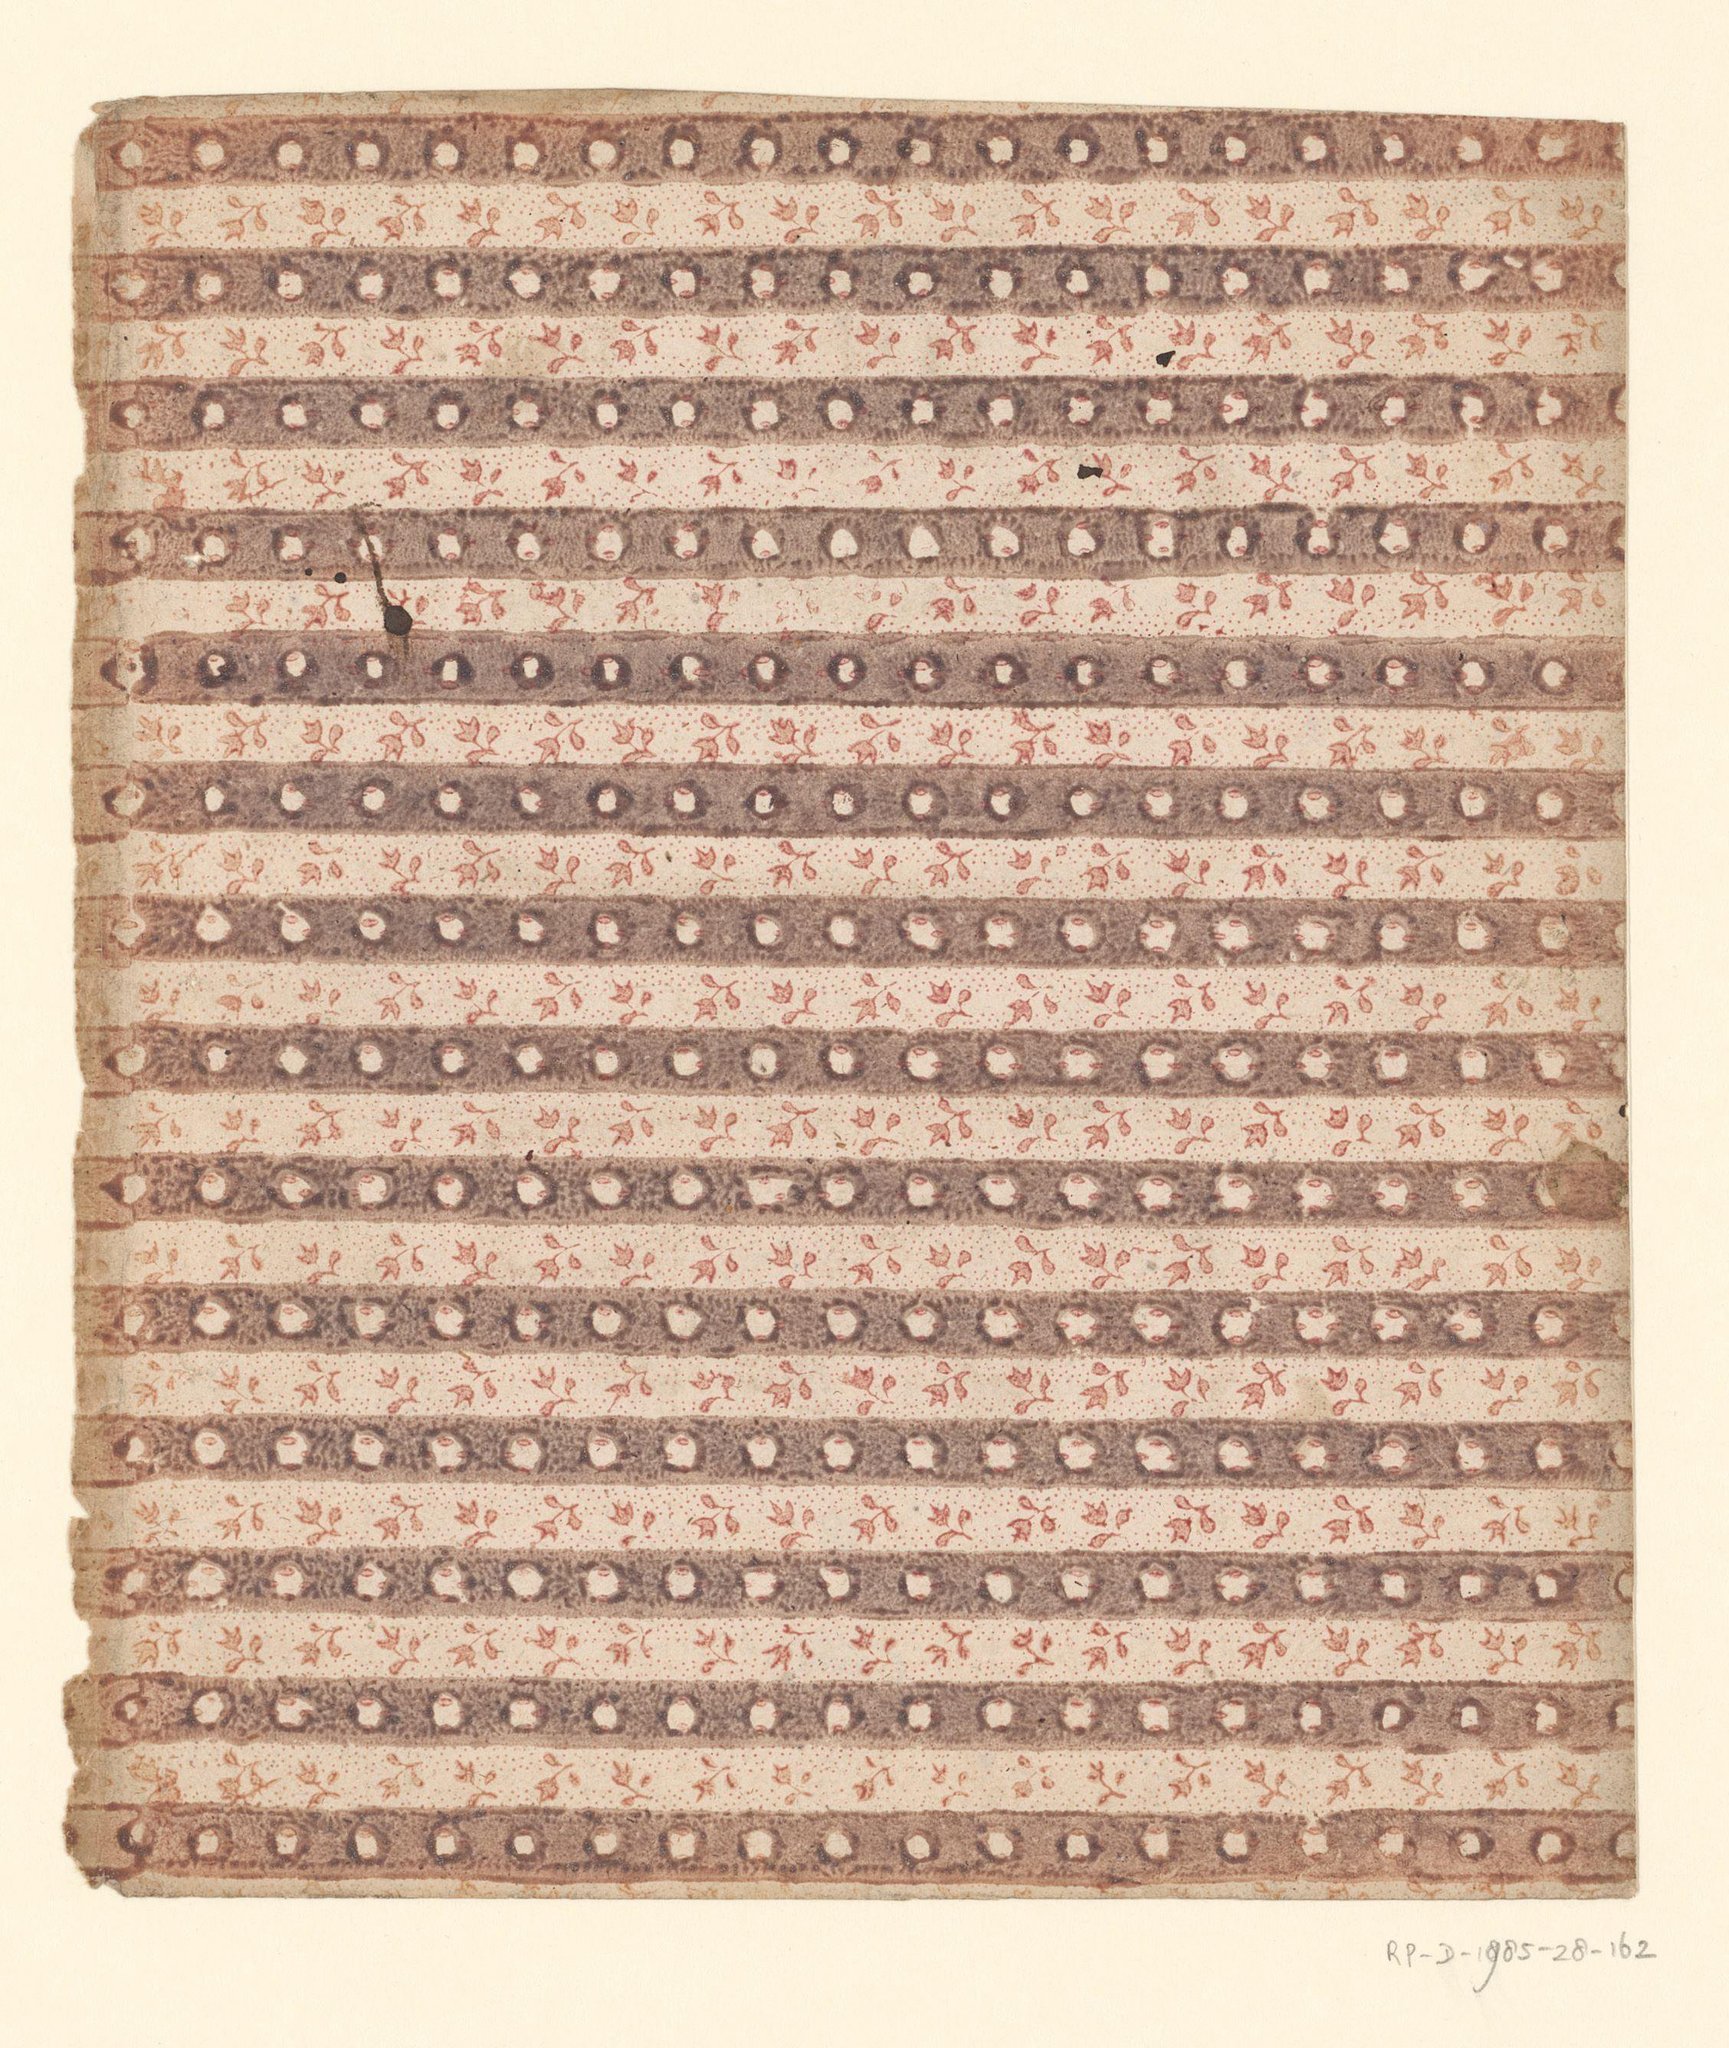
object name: printed paper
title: Blad met banenpatroon van bloem met puntenfond alternerend met baan met uitgespaarde stippen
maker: Anonymous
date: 1750-1900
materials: paper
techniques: printing block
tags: ornament derived from plant forms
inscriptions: collector's mark: Lugt 2228, collector's mark: Lugt 2760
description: Blad met banenpatroon van bloem met puntenfond alternerend met baan met uitgespaarde stippen. Helft van een omslag.